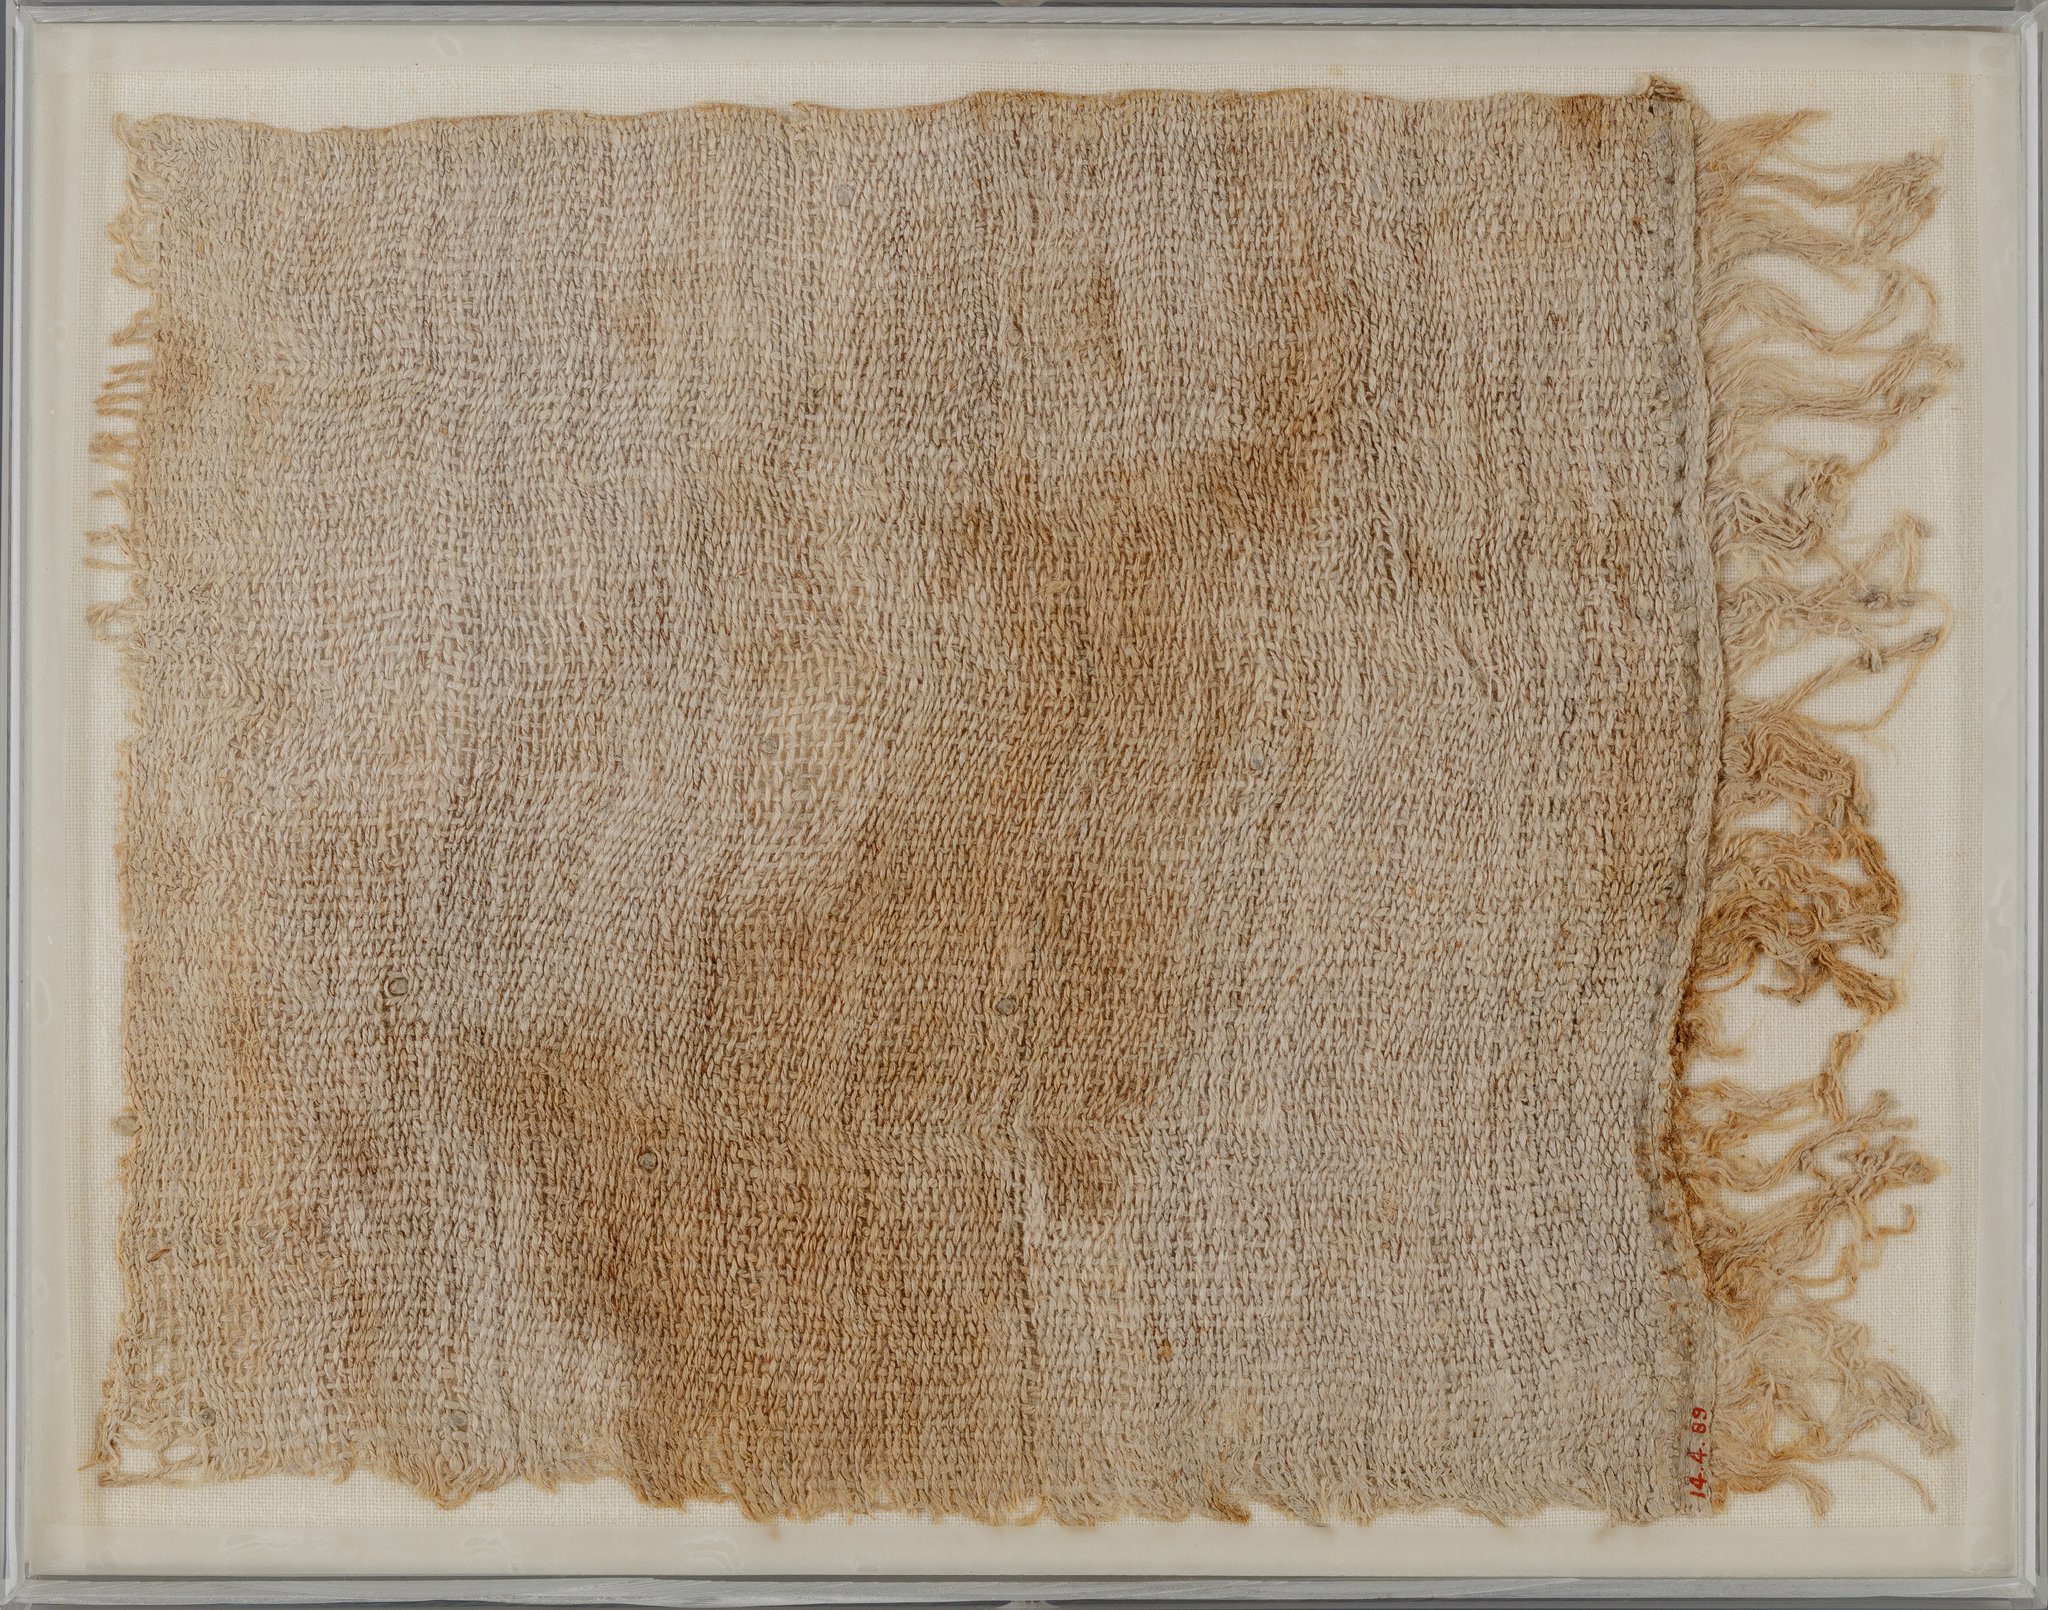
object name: linen fragment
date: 2880-2465 BCE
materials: linen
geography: egypt